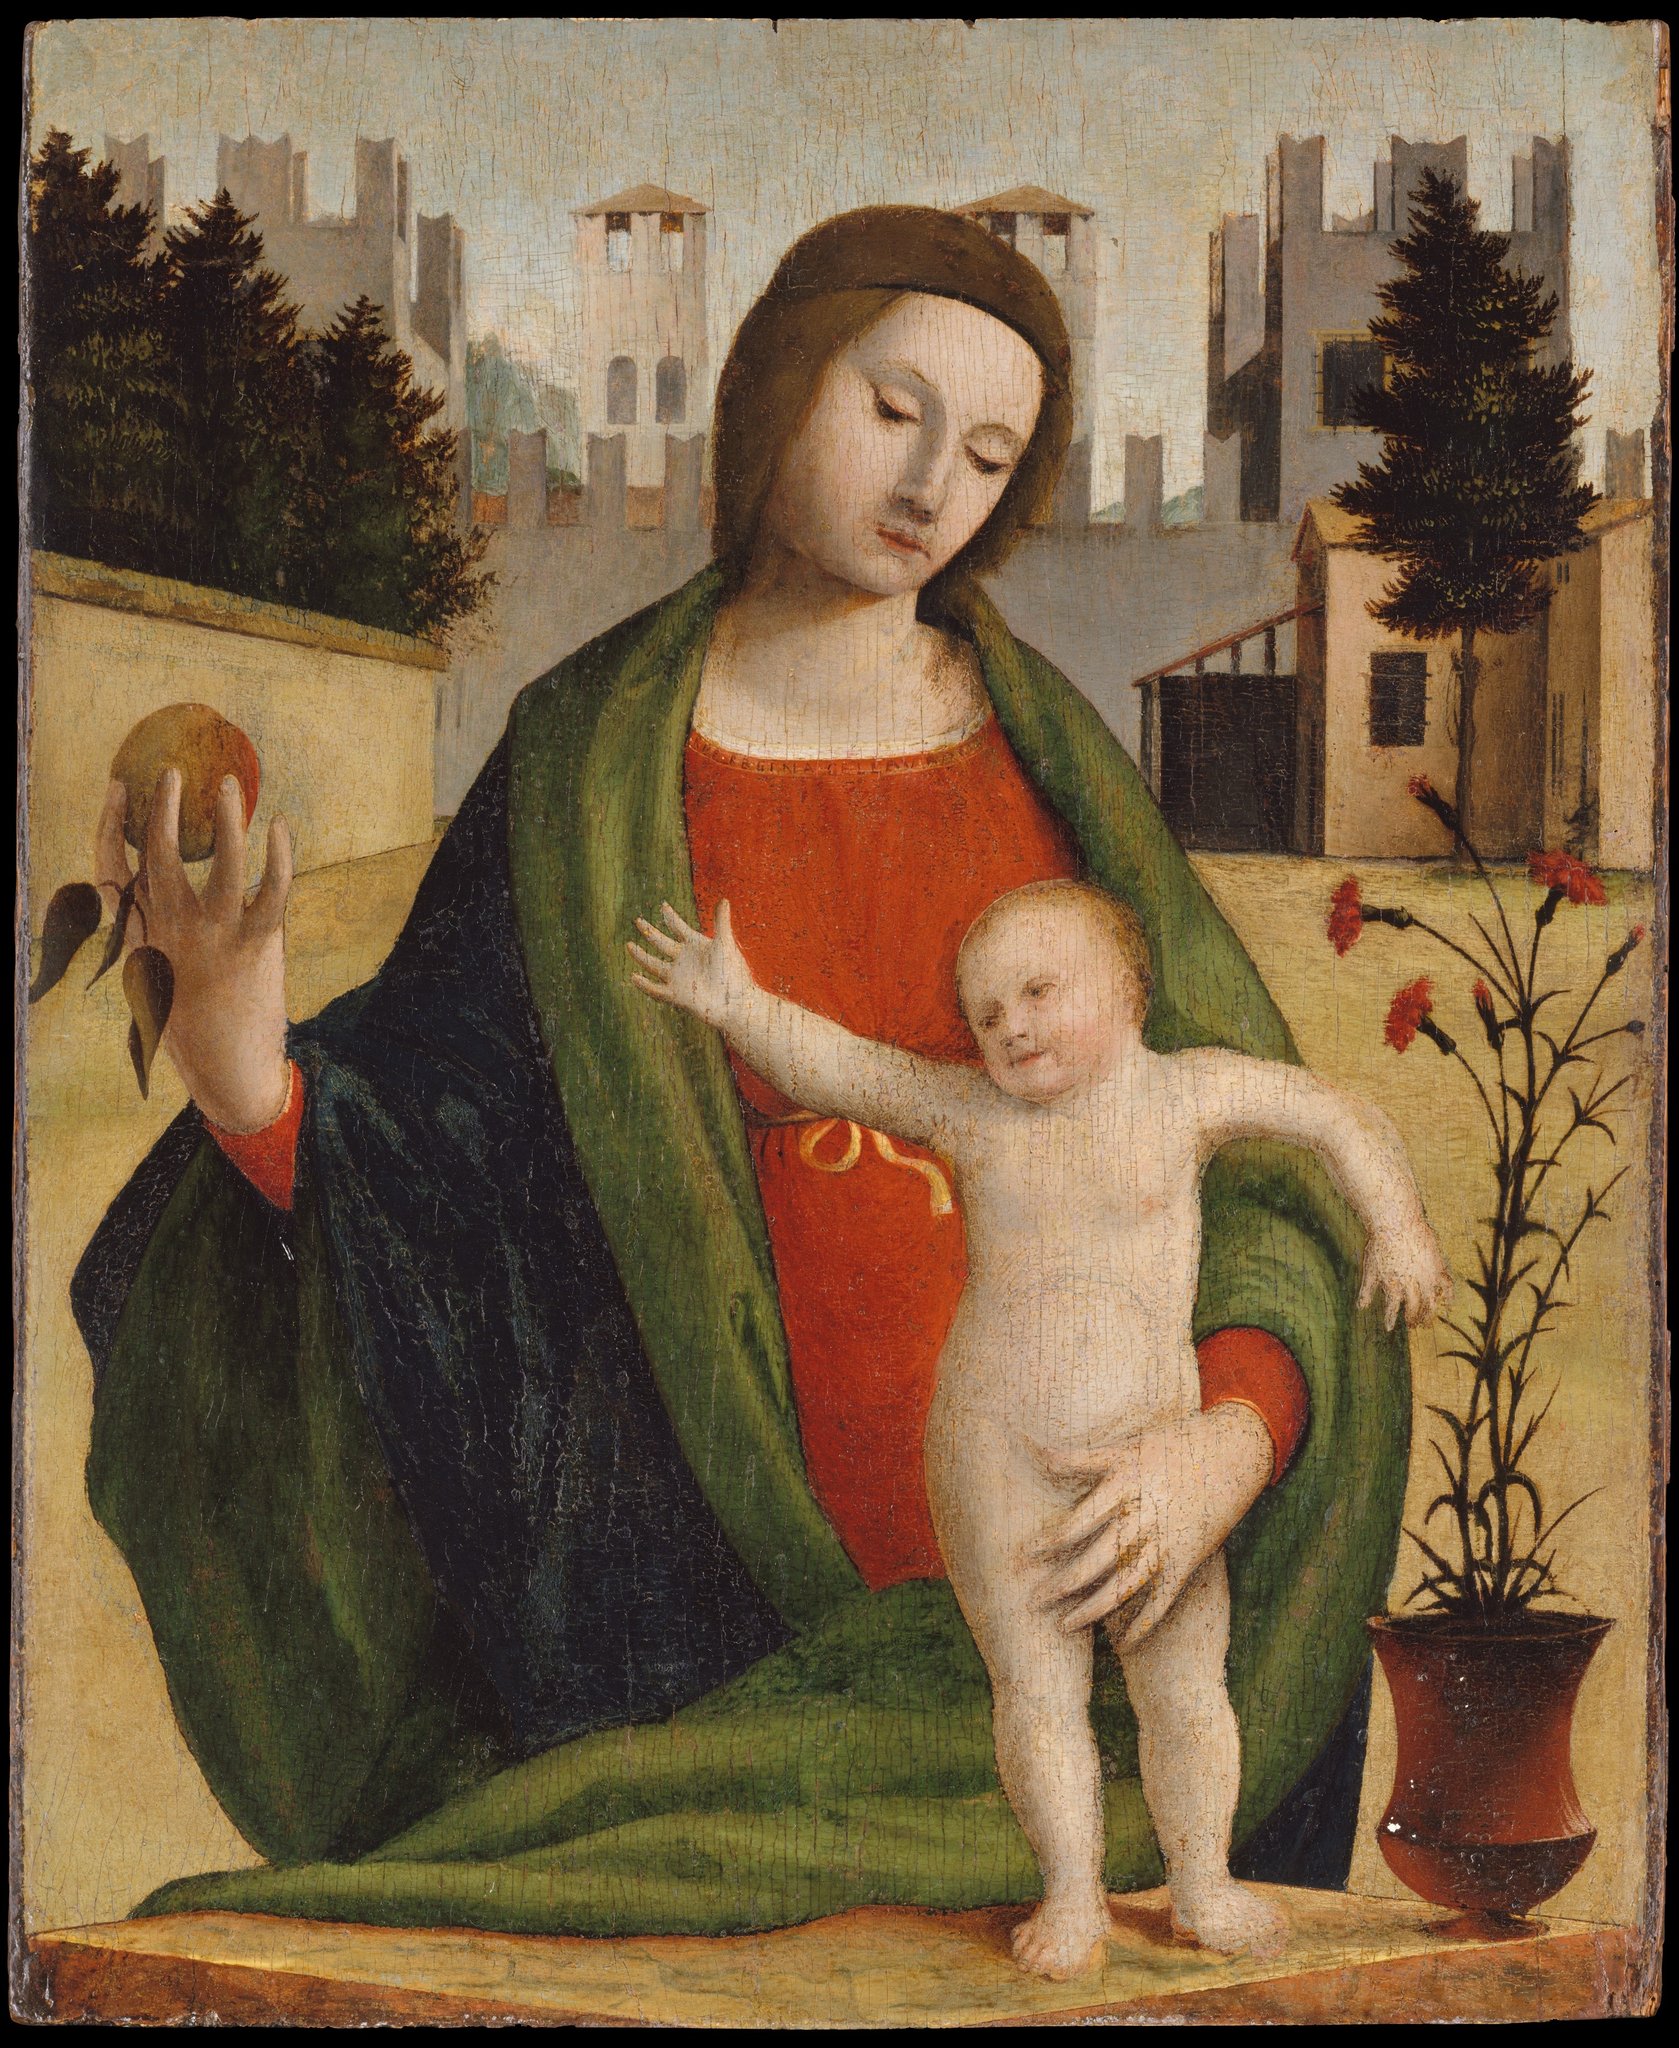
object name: painting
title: Madonna and Child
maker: bramantino (bartolomeo suardi)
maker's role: artist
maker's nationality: italian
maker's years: 1460-1530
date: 1508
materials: paint, wood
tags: apples,madonna and child